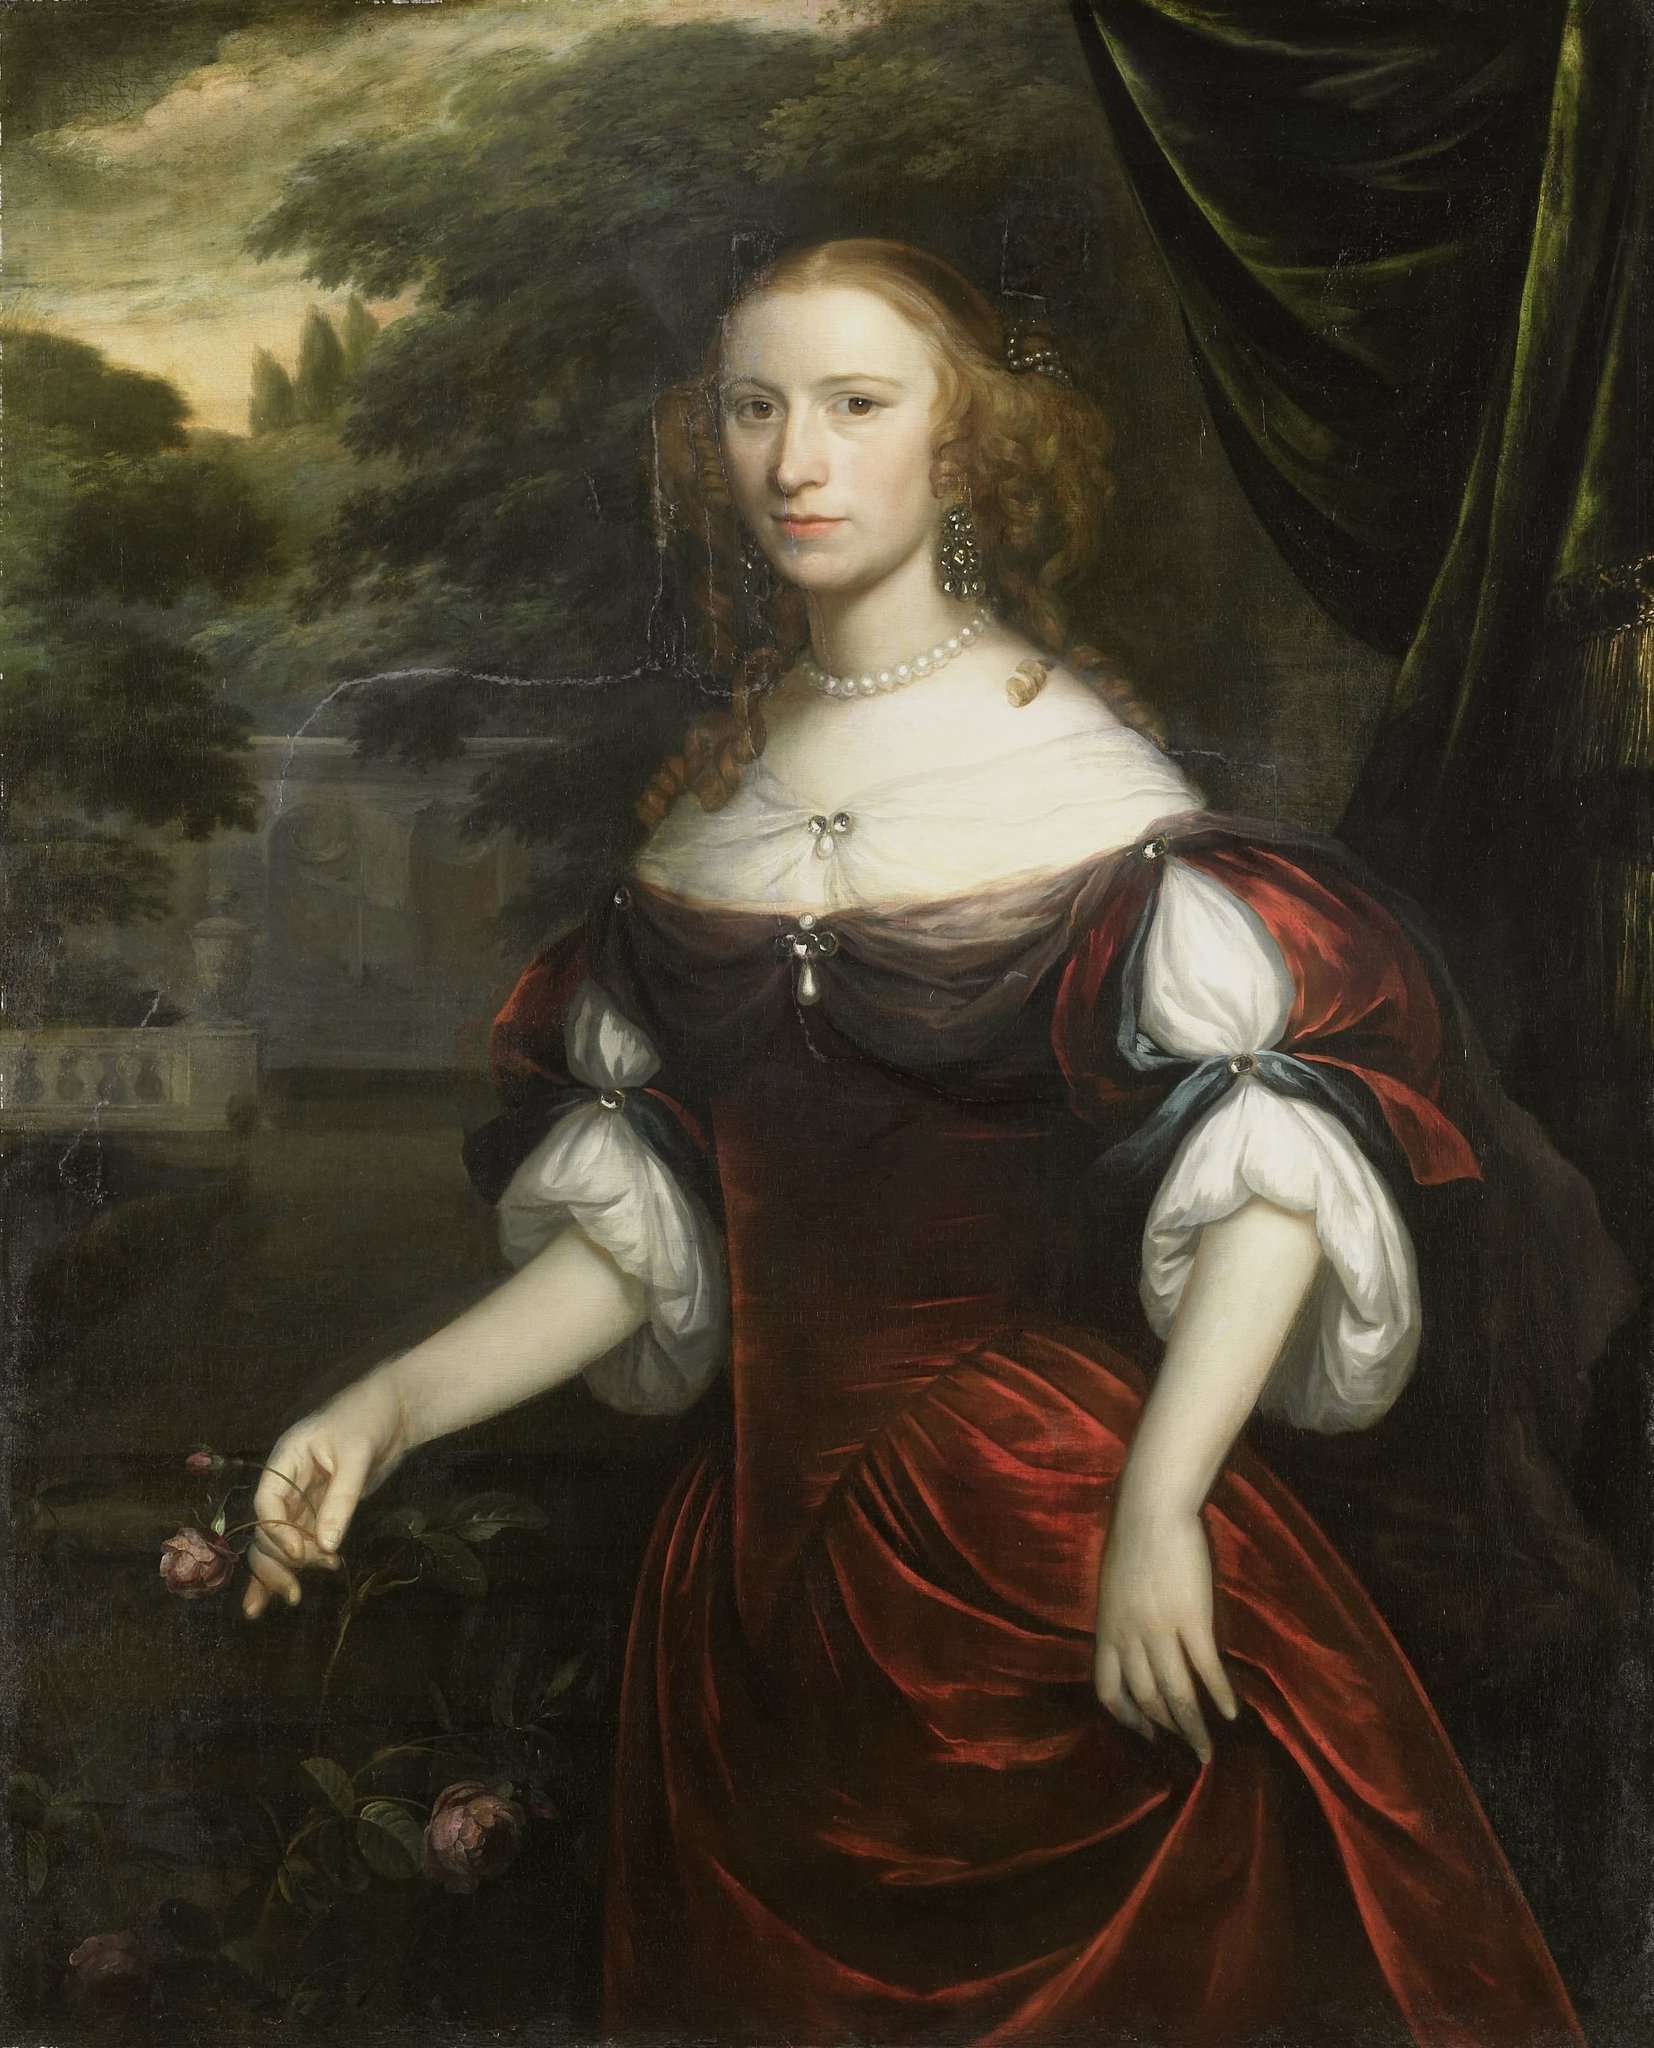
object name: painting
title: Portrait of a Woman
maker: herman verelst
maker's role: painter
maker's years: 1641-1702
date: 1667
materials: canvas, oil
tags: anonymous historical person portrayed - bb - woman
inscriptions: signature and date: ‘H. Verelst. F. Aº 1667’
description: Portret van een vrouw. Kniestuk, staande met een roos in de rechterhand. Op de achtergrond een tuin. Pendant van SK-C-24.